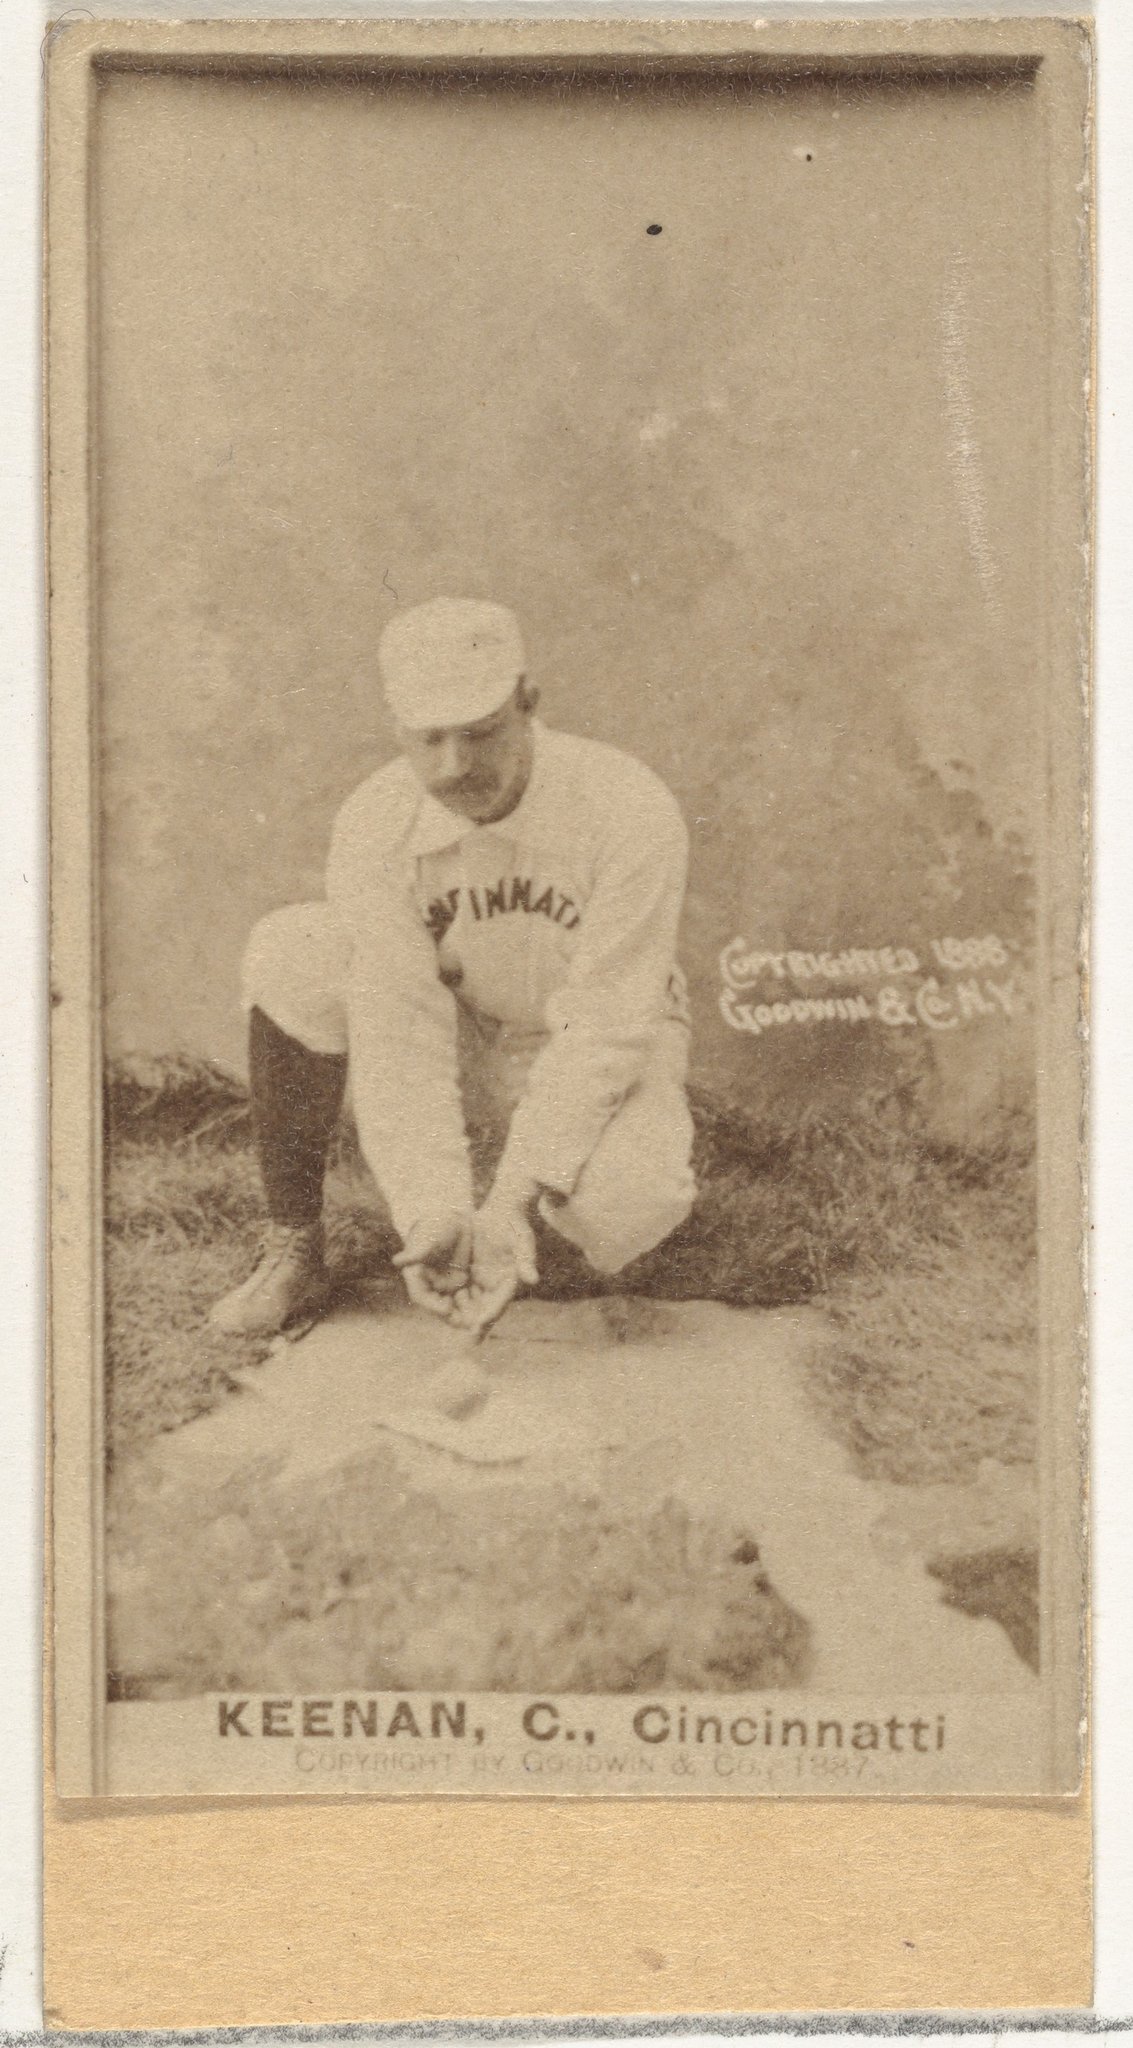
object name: baseball card, photograph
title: James William "Jim" Keenan, Catcher, Cincinnati, from the Old Judge series (N172) for Old Judge Cigarettes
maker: goodwin & company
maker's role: publisher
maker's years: 1850-1950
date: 1887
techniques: albumen silver print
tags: men,portraits,baseball,athletes